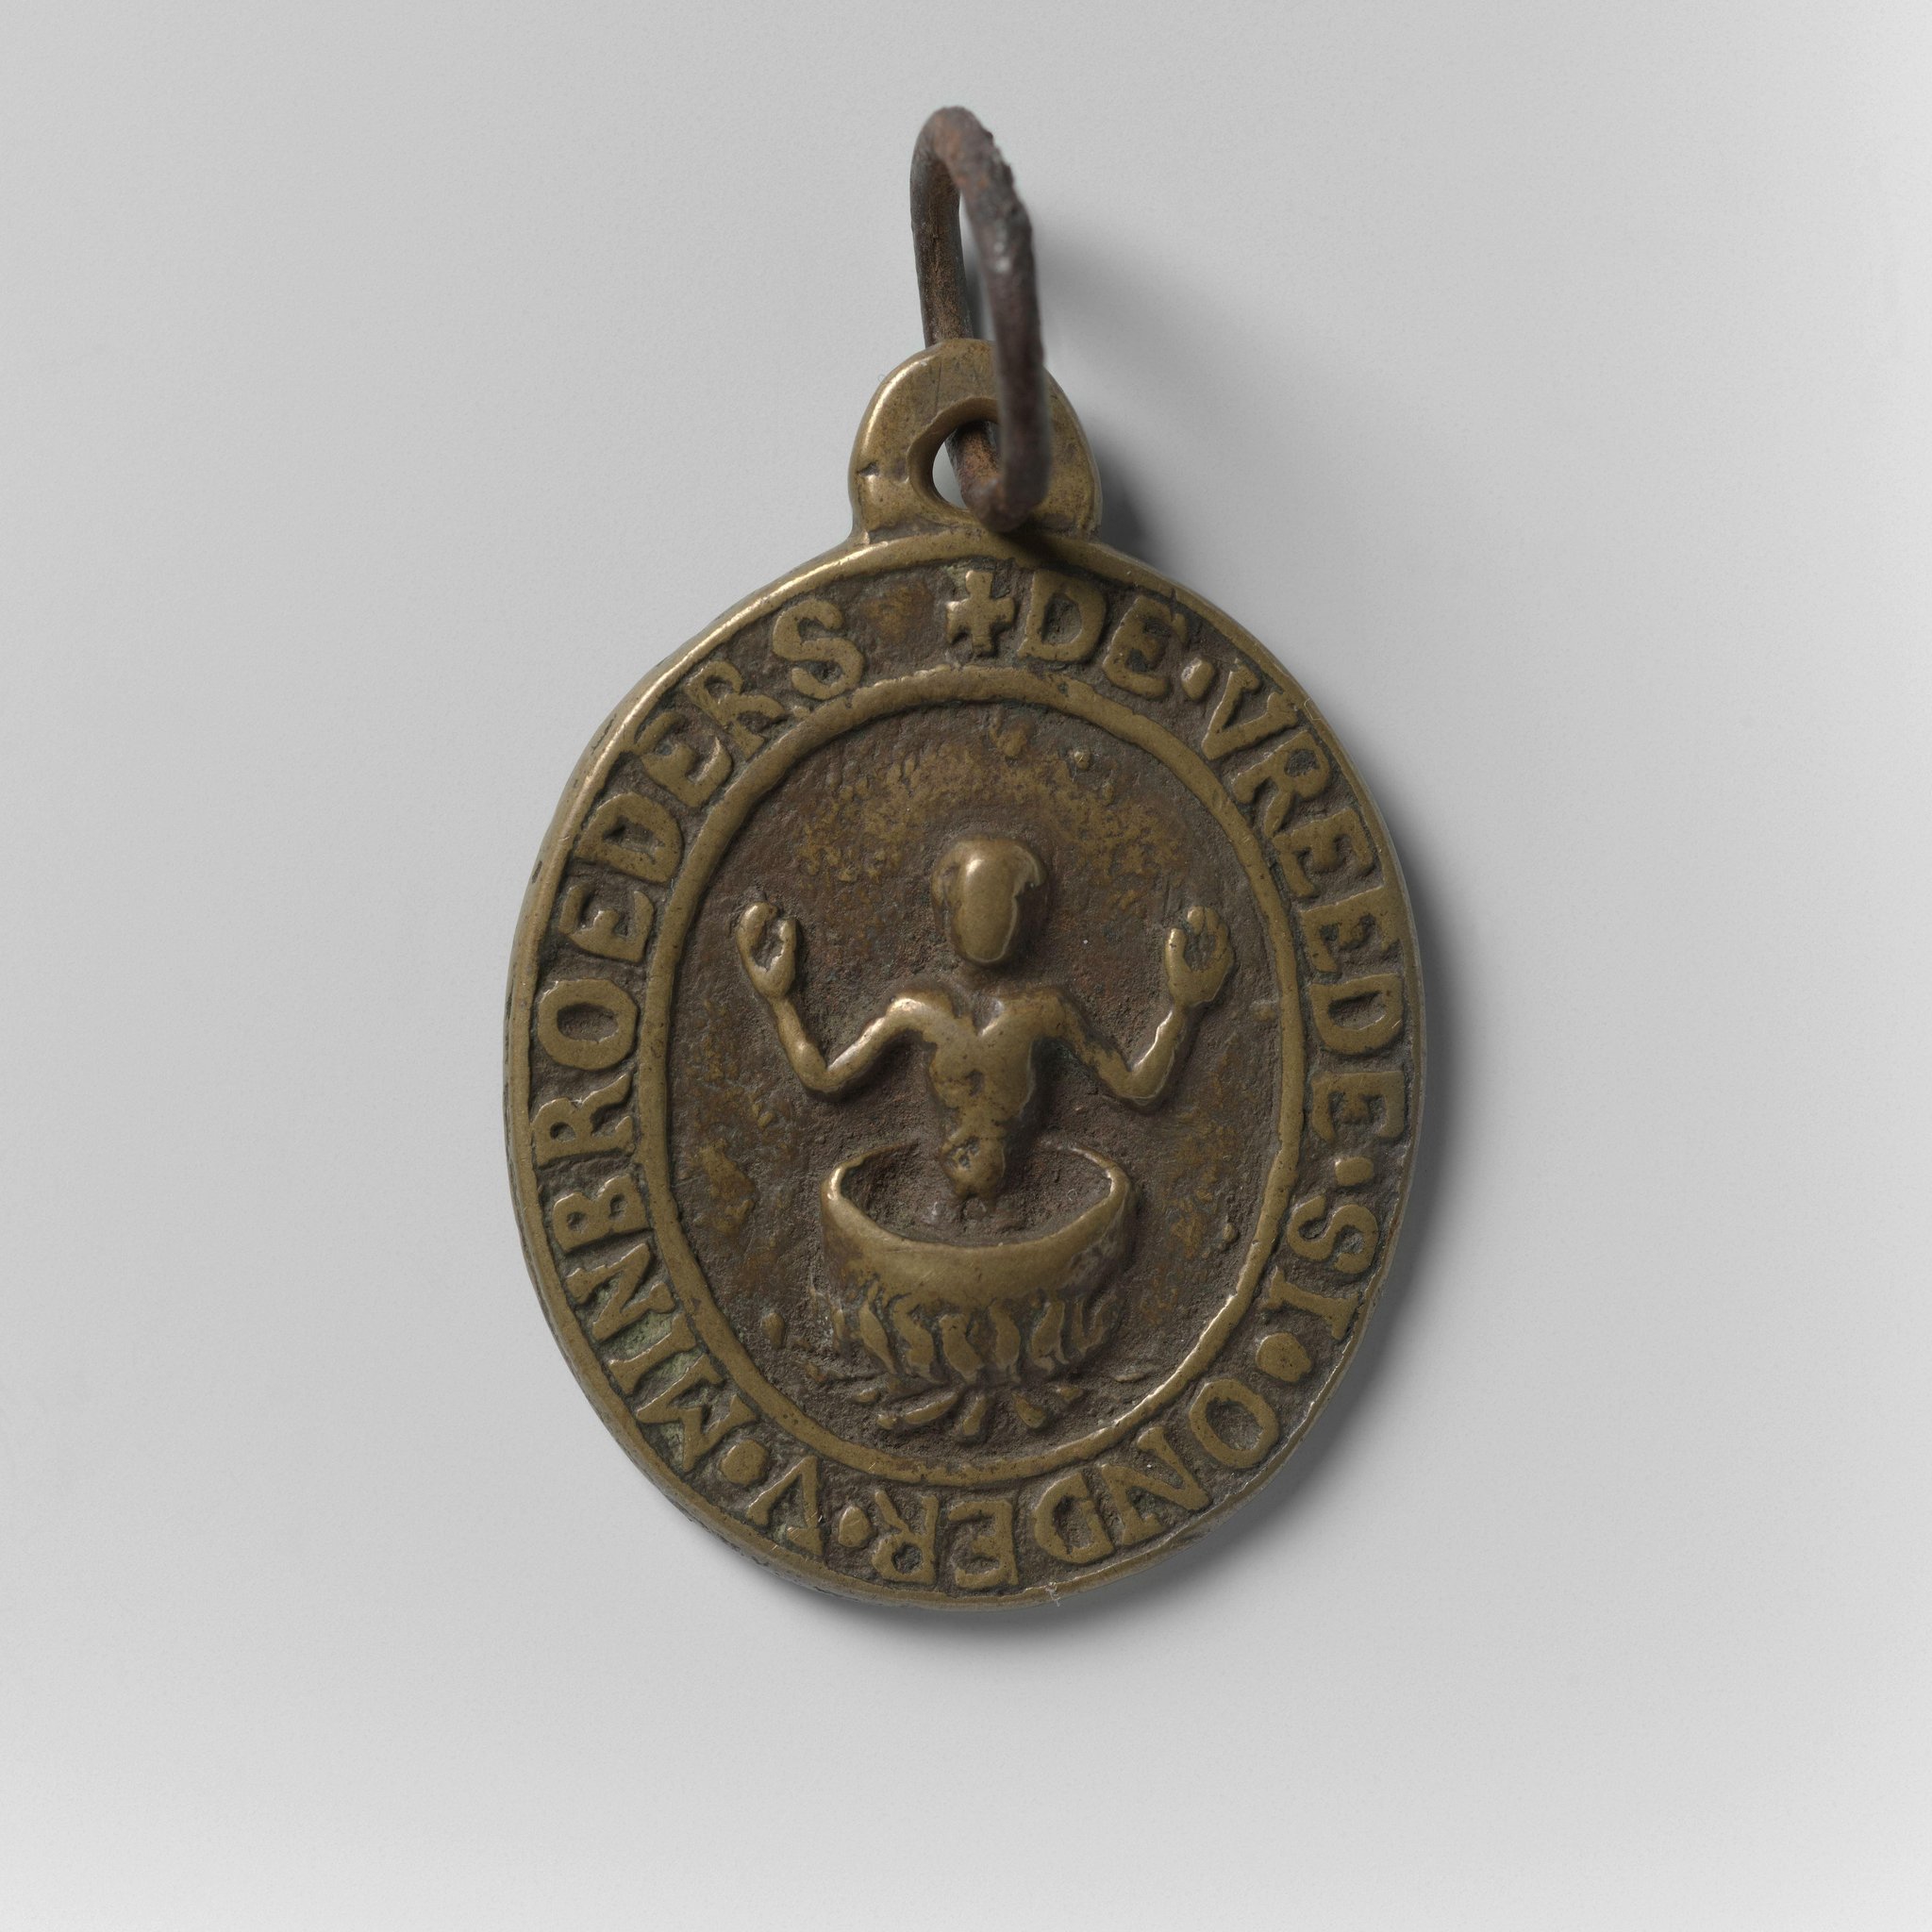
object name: history medal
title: Presentiepenning van het Molenaarsgilde te 's Hertogenbosch 1691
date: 1691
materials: brass, iron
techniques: casting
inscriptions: circumscription: ‘+DE.VREEDE.SI.ONDER.V.MINBROEDERS’, circumscription: ‘+DENCKT.OP.HET.OORDEL.GODTS.1691’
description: Gegoten ovalen messing draagpenning met oog aan ijzeren ring, op de voorzijde Christus in een doopvont met omschrift, op de keerzijde een molen met omschrift